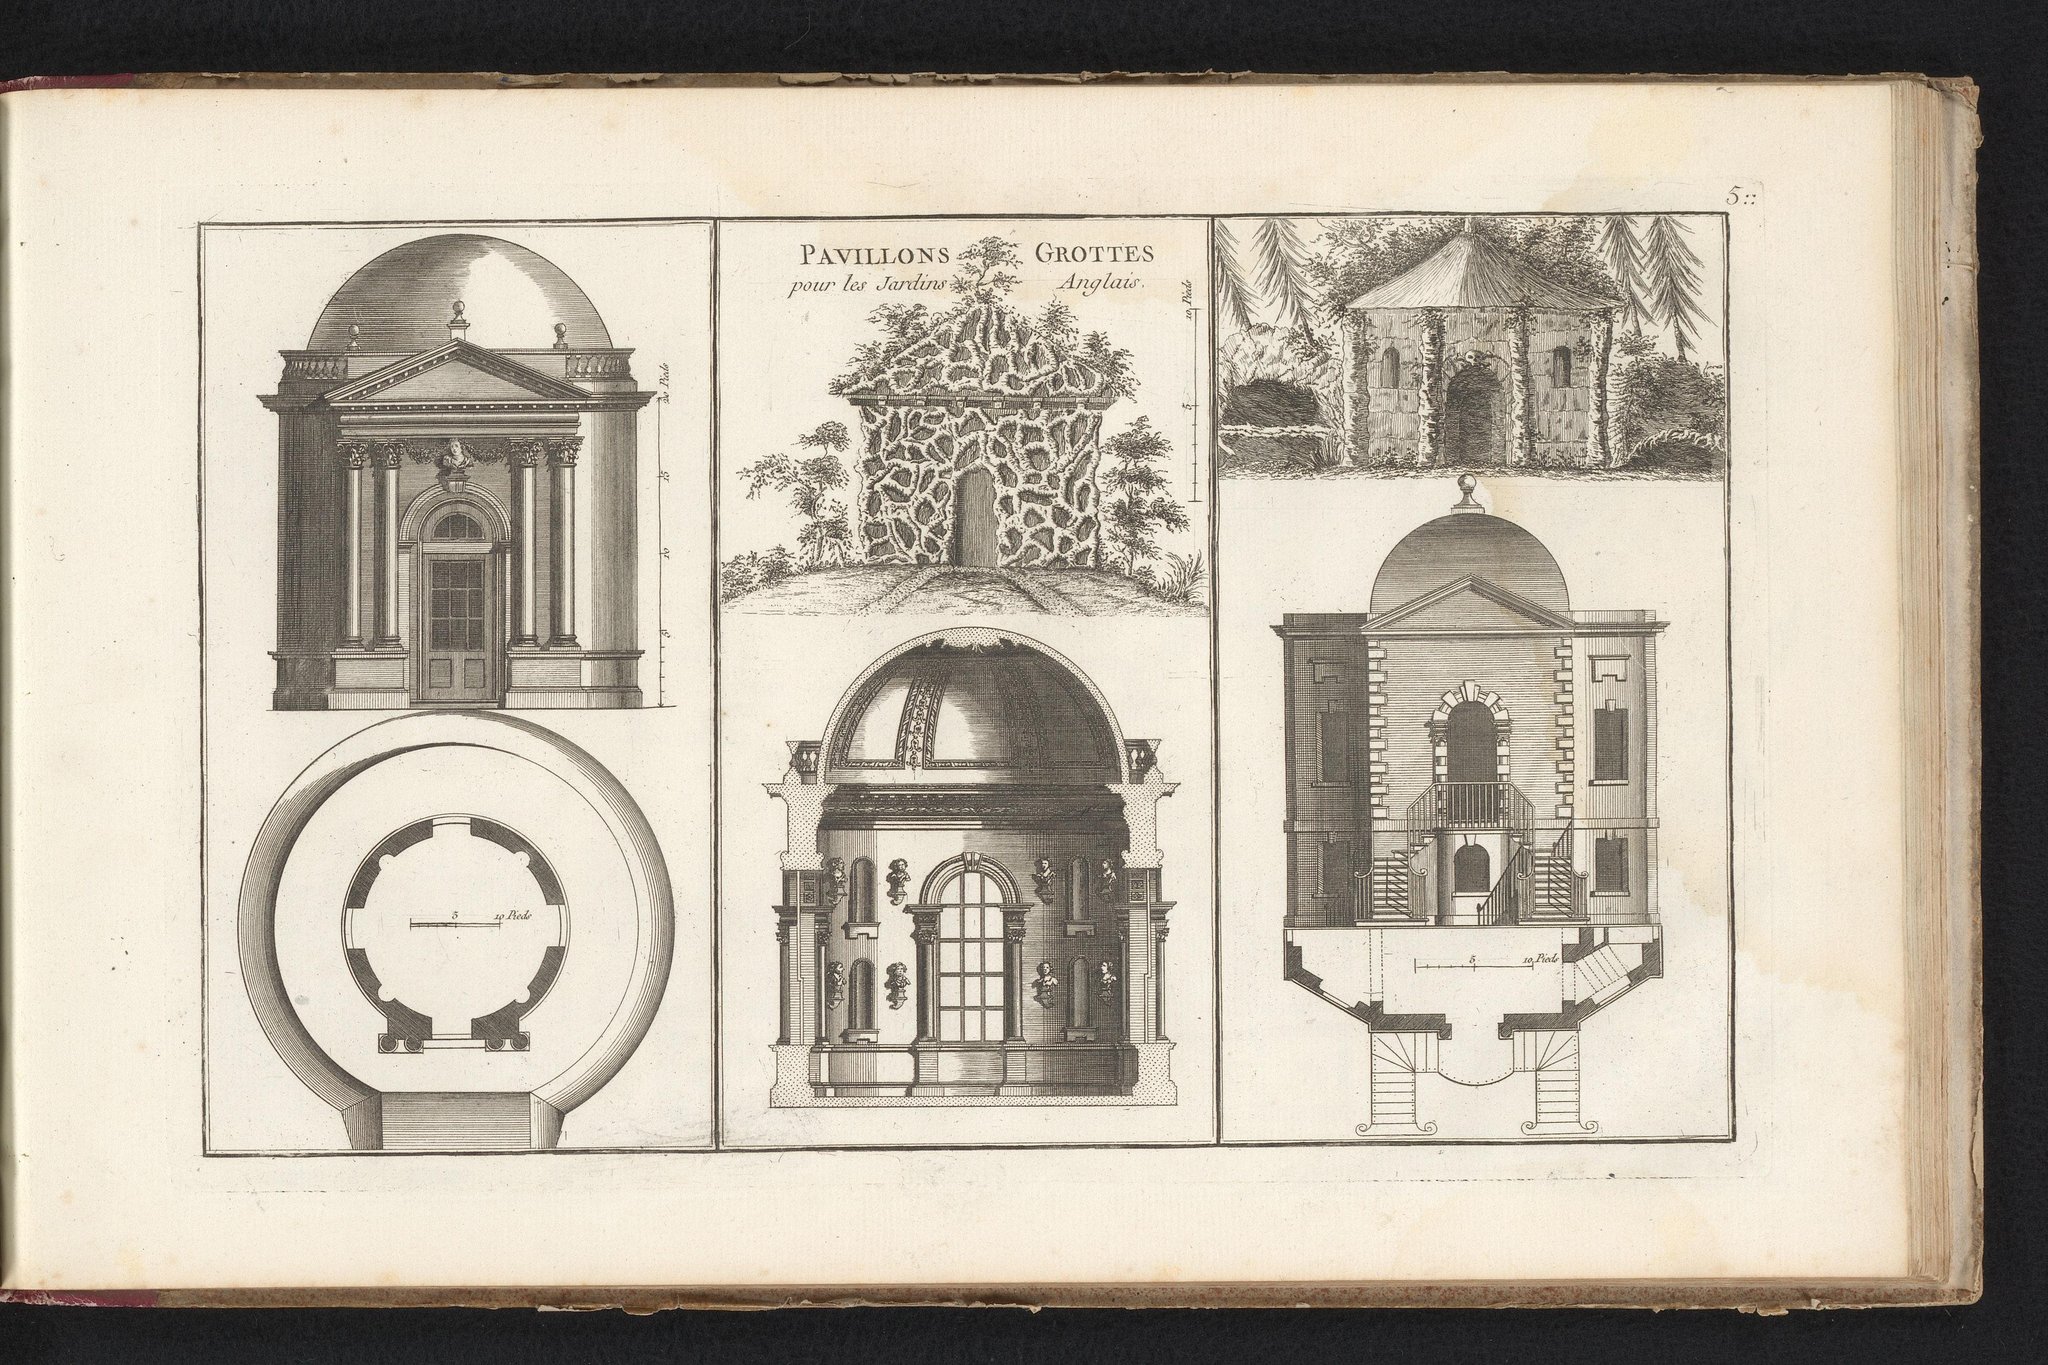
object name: print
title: Pavillons grottes pour les jardins anglais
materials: paper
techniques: engraving, etching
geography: paris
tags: garden buildings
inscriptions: collector's mark: Lugt 2228, collector's mark: Lugt 2760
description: De serie 'Jardins anglo-chinois à la mode' verscheen in totaal in 21 zogeheten 'cahiers' (afleveringen). De huidige prent komt uit het vierde 'cahier'. Het Rijksmuseum Amsterdam bezit drie banden met daarin in totaal zes 'cahiers' van deze reeks. In de documentatie wordt verwezen naar een in de bibliotheek van het Rijksmuseum Amsterdam aanwezige facsimile van het complete werk.